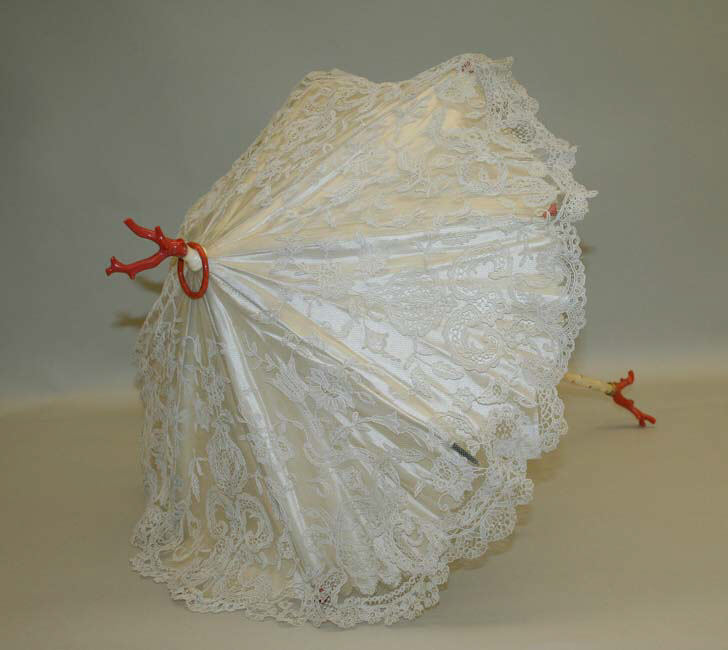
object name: parasol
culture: american or european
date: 1851-1875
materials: coral, cotton, ivory, metal, silk